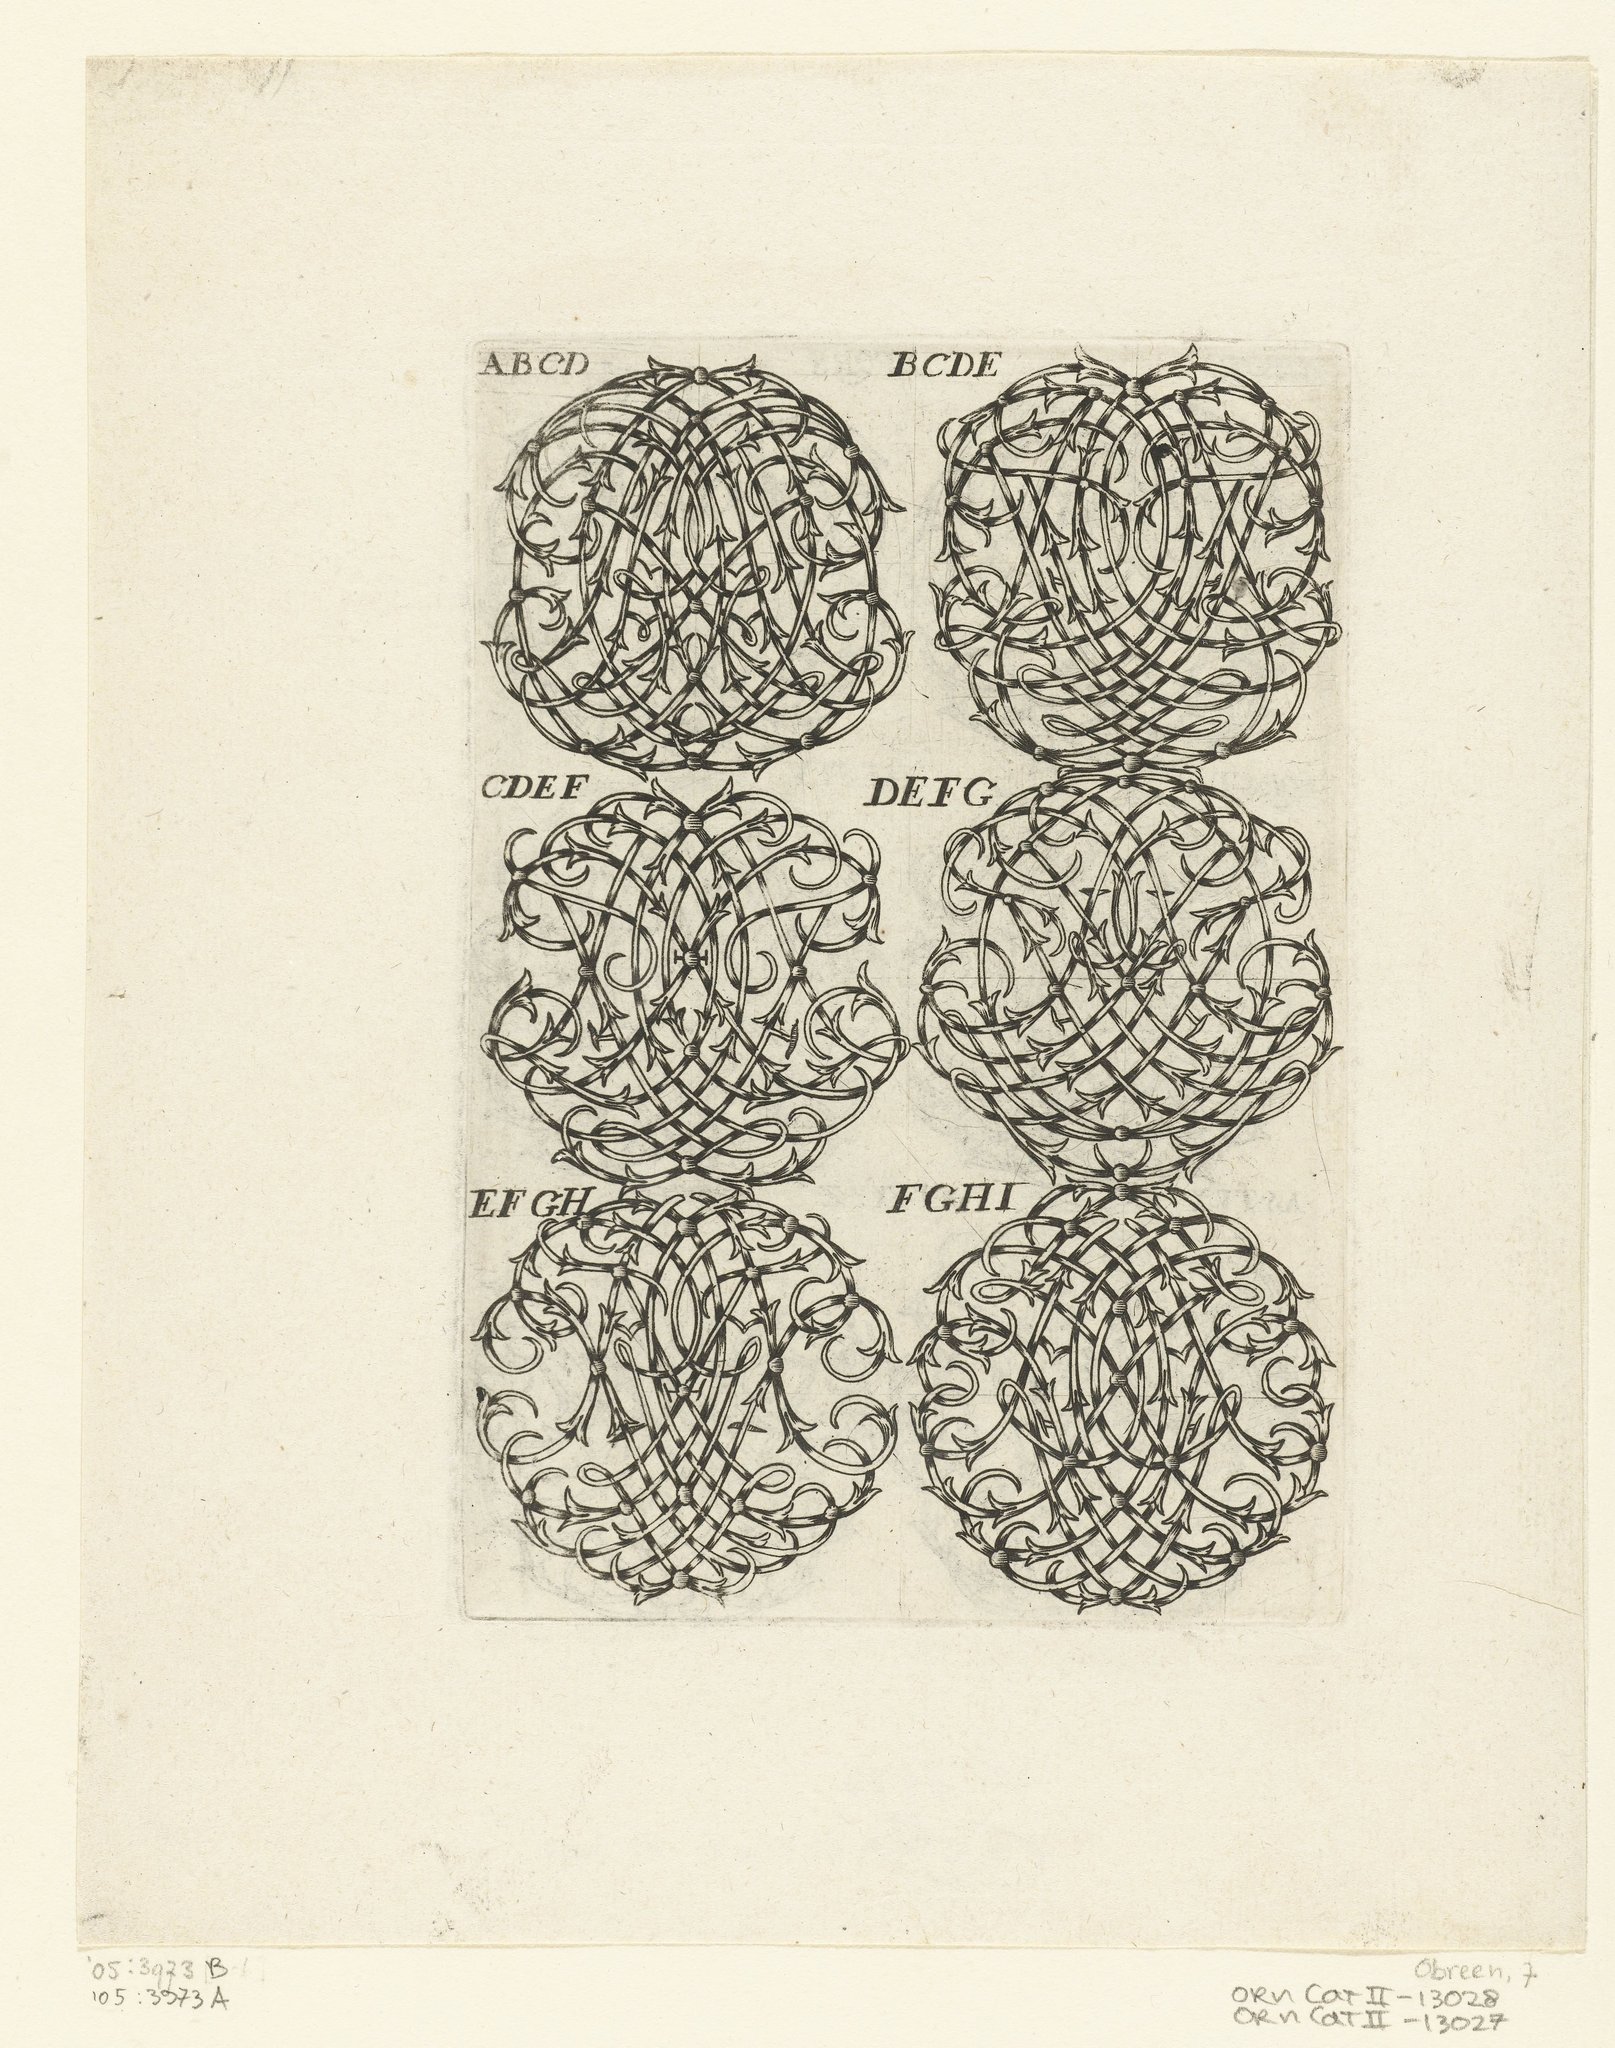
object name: ornament print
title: Livre nouveau et utile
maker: daniel de lafeuille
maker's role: print maker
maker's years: 1640-1709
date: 1690-1691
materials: paper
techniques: engraving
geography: amsterdam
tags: letters, alphabet, script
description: Uit serie van 29 deels genummerde bladen met cijfermonogrammen.